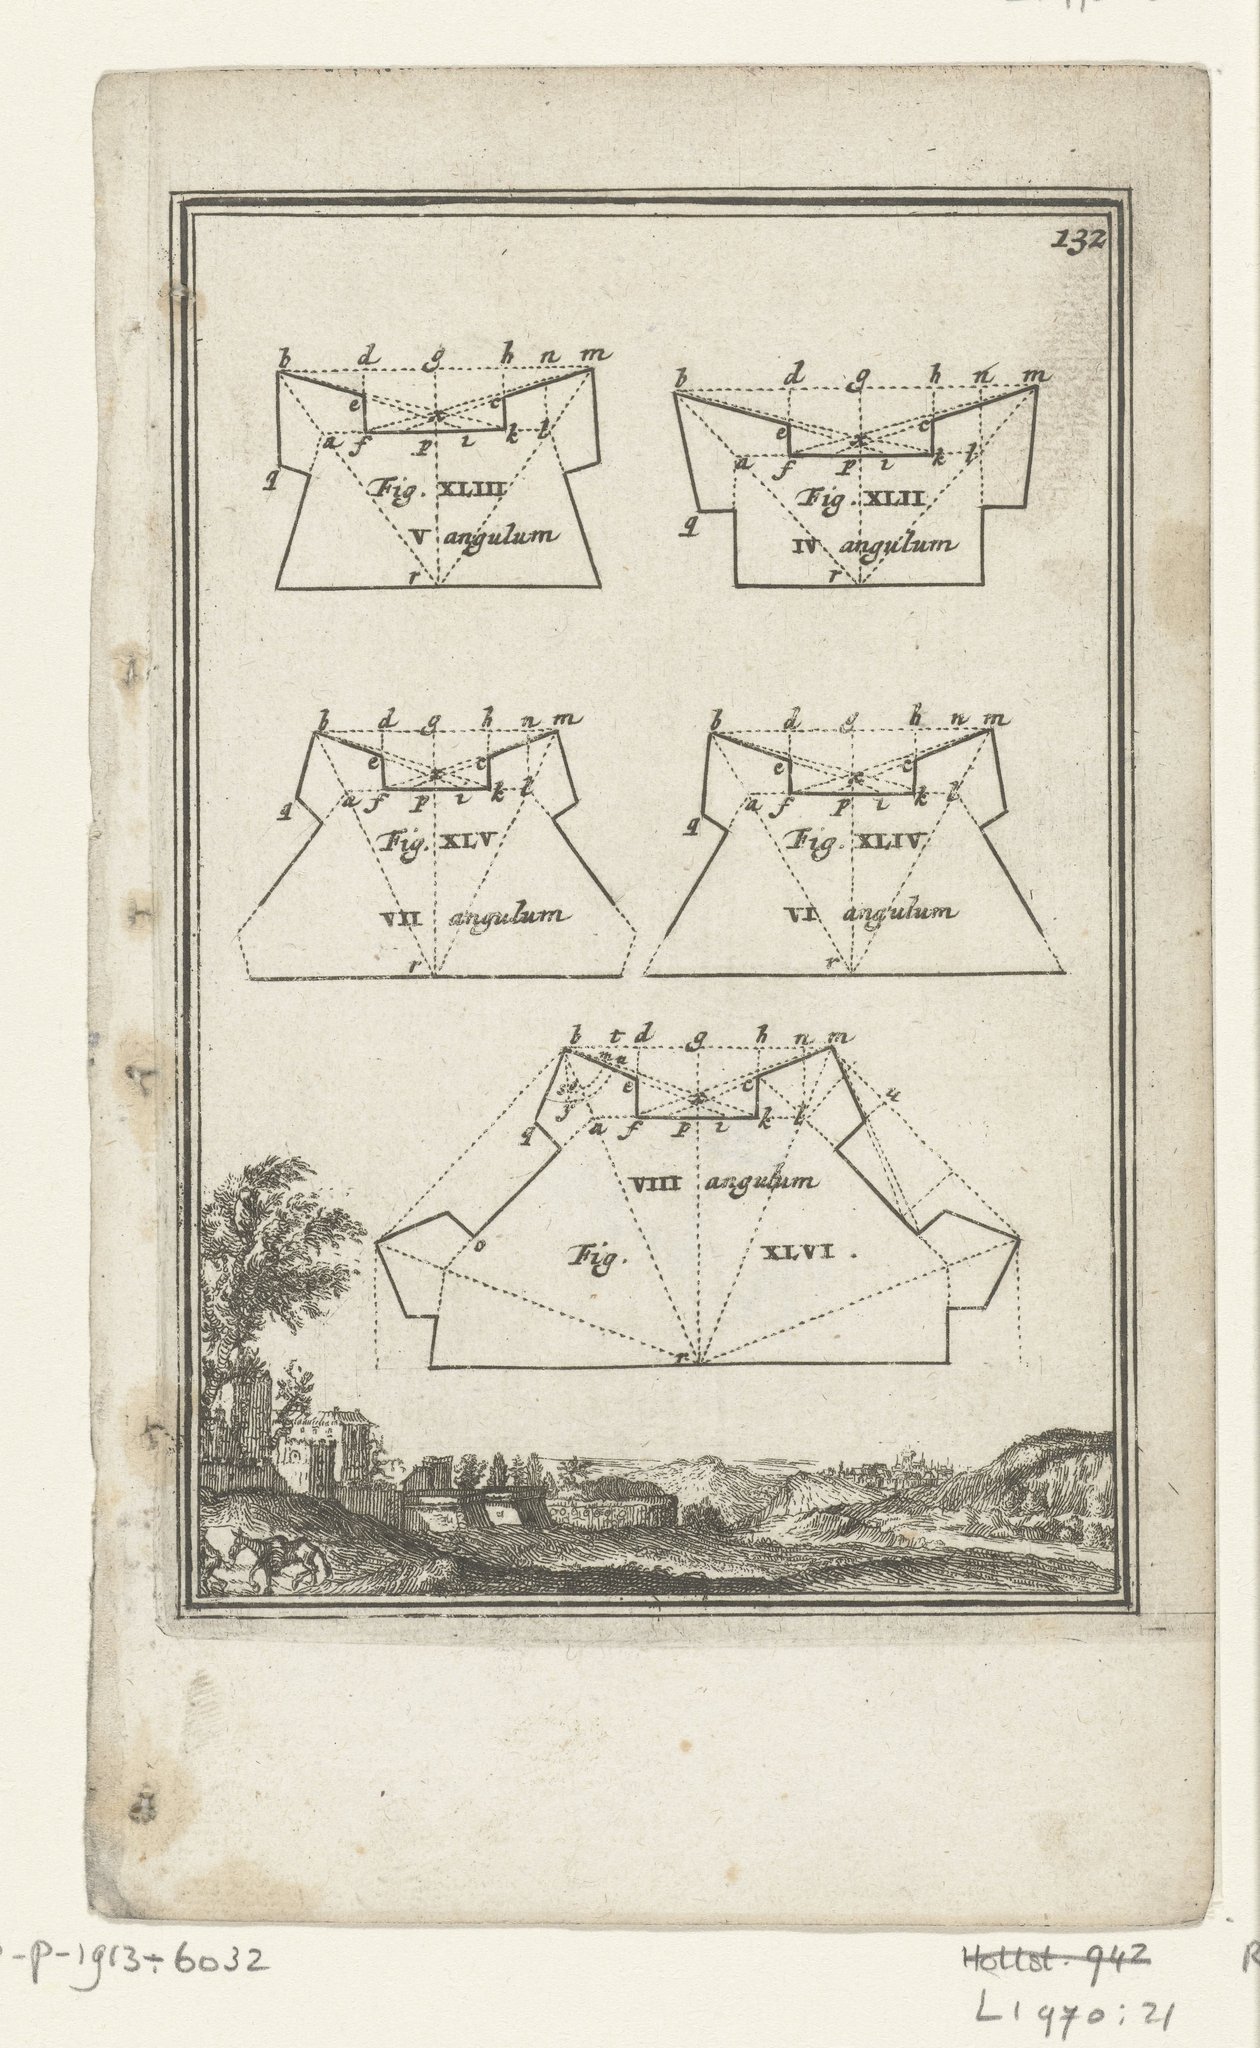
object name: book illustration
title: Illustratie voor 'Den Arbeid van Mars' van Allain Manesson Mallet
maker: romeyn de hooghe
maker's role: draughtsman, goldsmith, painter, print maker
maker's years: 1645-1708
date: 1672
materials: paper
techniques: etching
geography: amsterdam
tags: prospect of village, silhouette of village, fortifications, military engineering, prospect of city, town panorama, silhouette of city, mathematics, mountains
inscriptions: collector's mark: Lugt 2228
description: Vijf wiskundige figuren (hoekberekeningen). Daaronder een bergachtig landschap met enige bebouwing. In de hoek rechtsboven het cijfer 132 (= het nummer van de pagina in het boek waartegenover de illustratie geplaatst is).